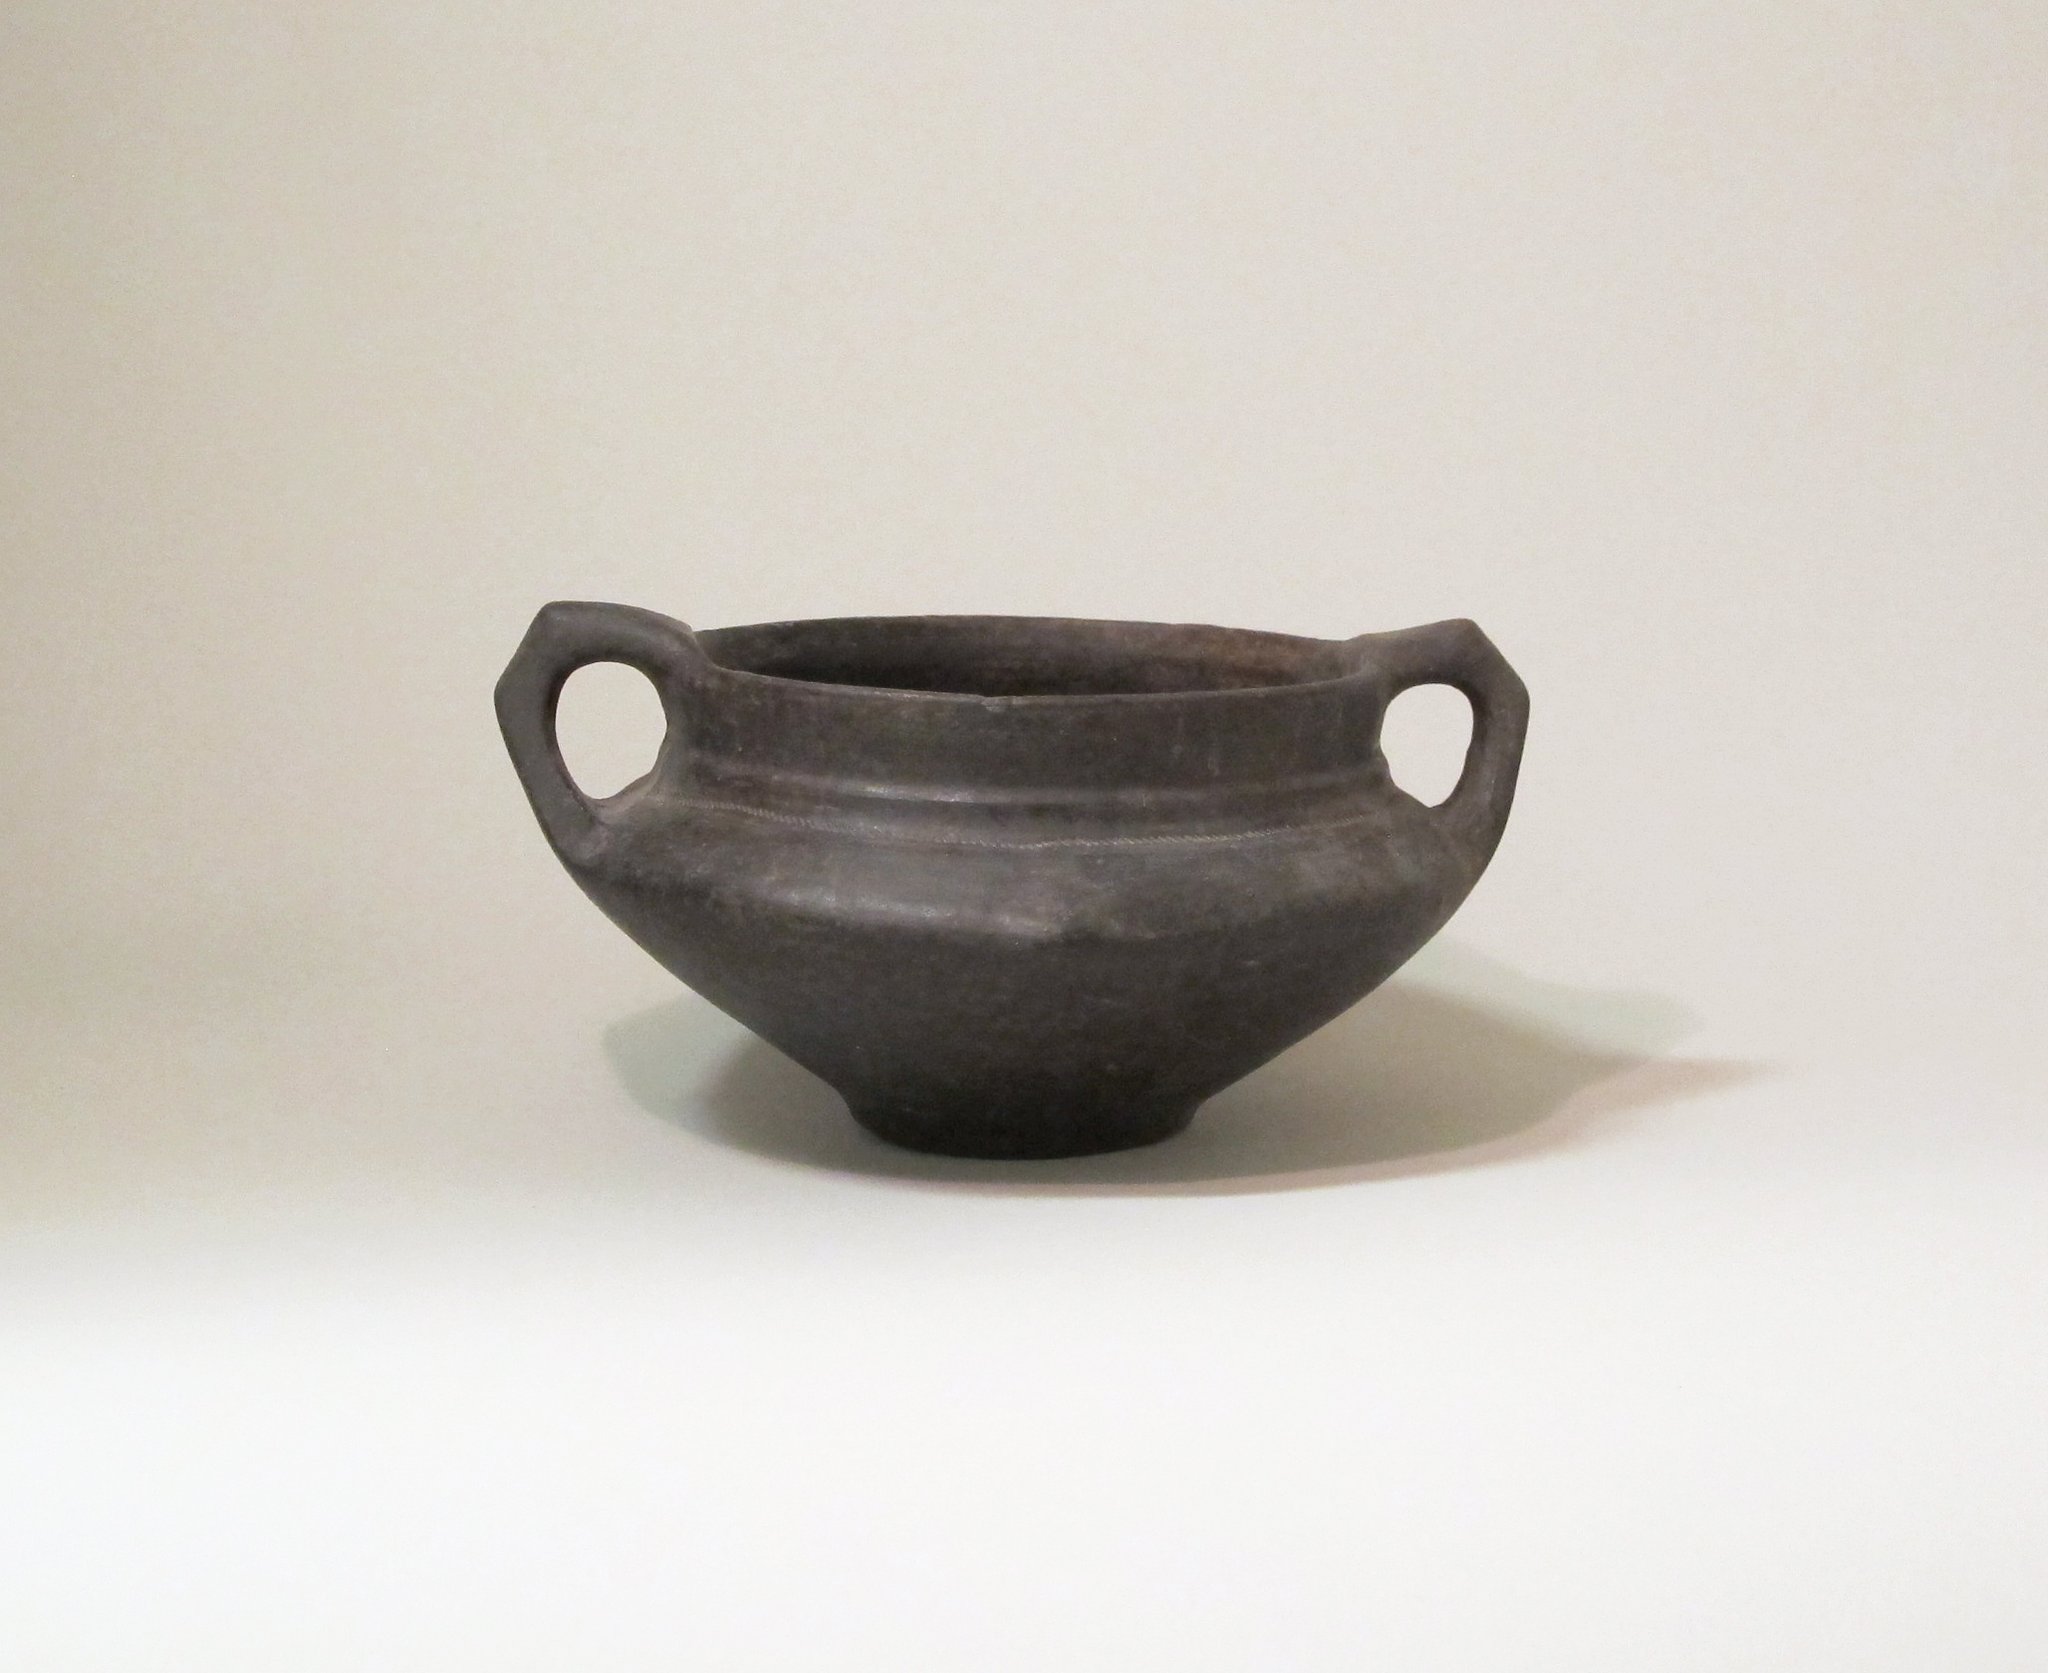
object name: jar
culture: etruscan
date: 700-675 BCE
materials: terracotta